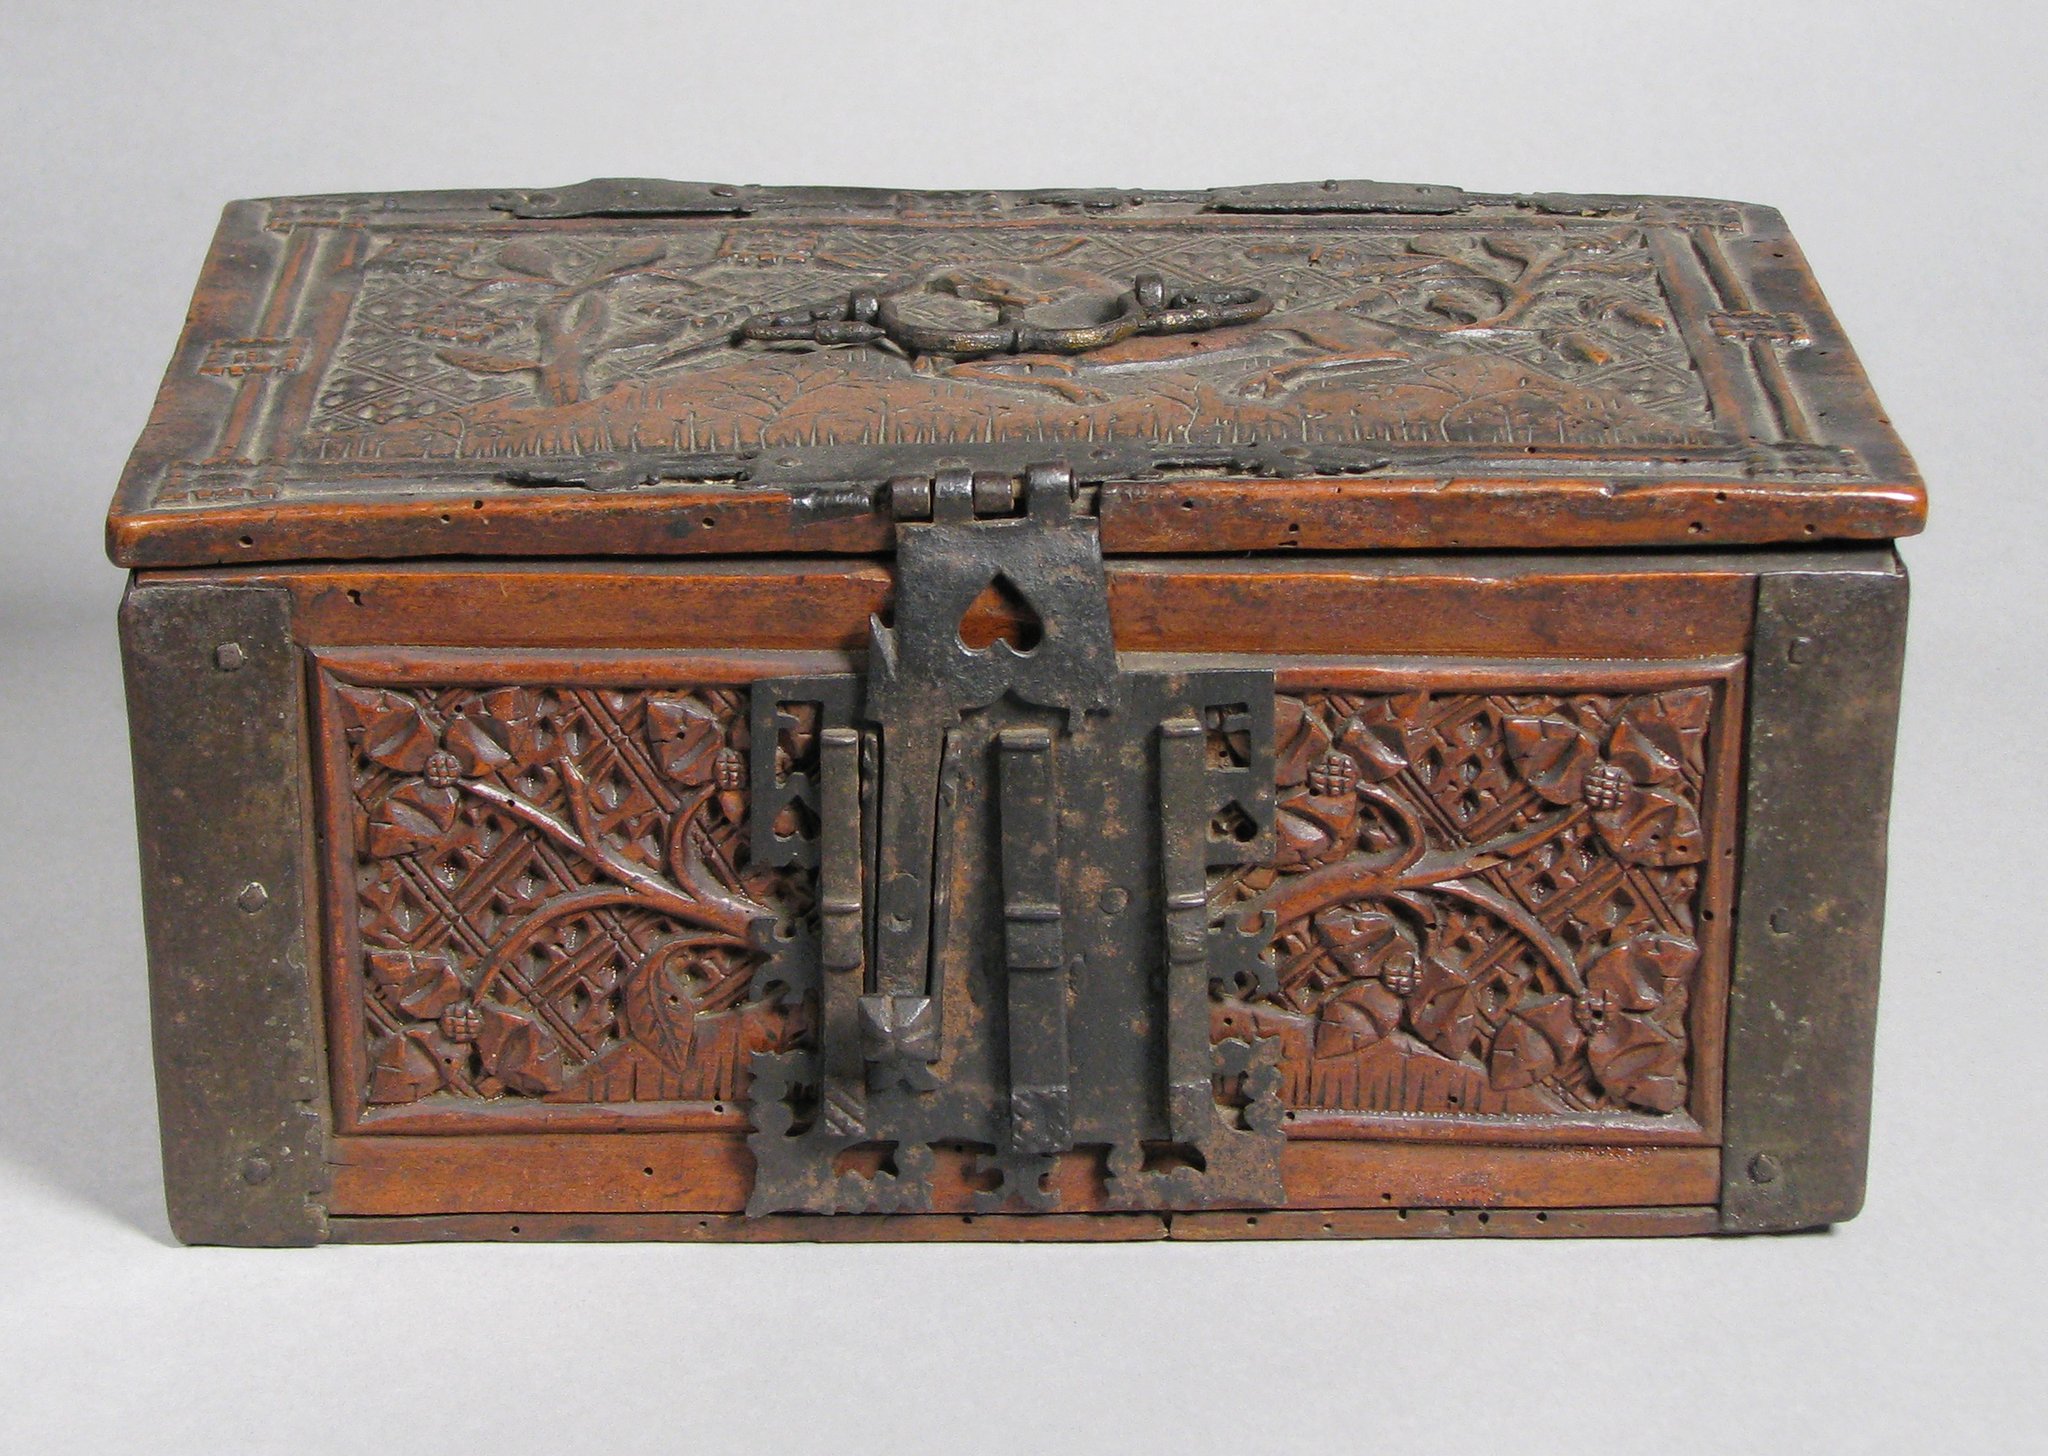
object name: box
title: Box with Unicorn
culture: northern european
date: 1401-1500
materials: iron, wood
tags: unicorns